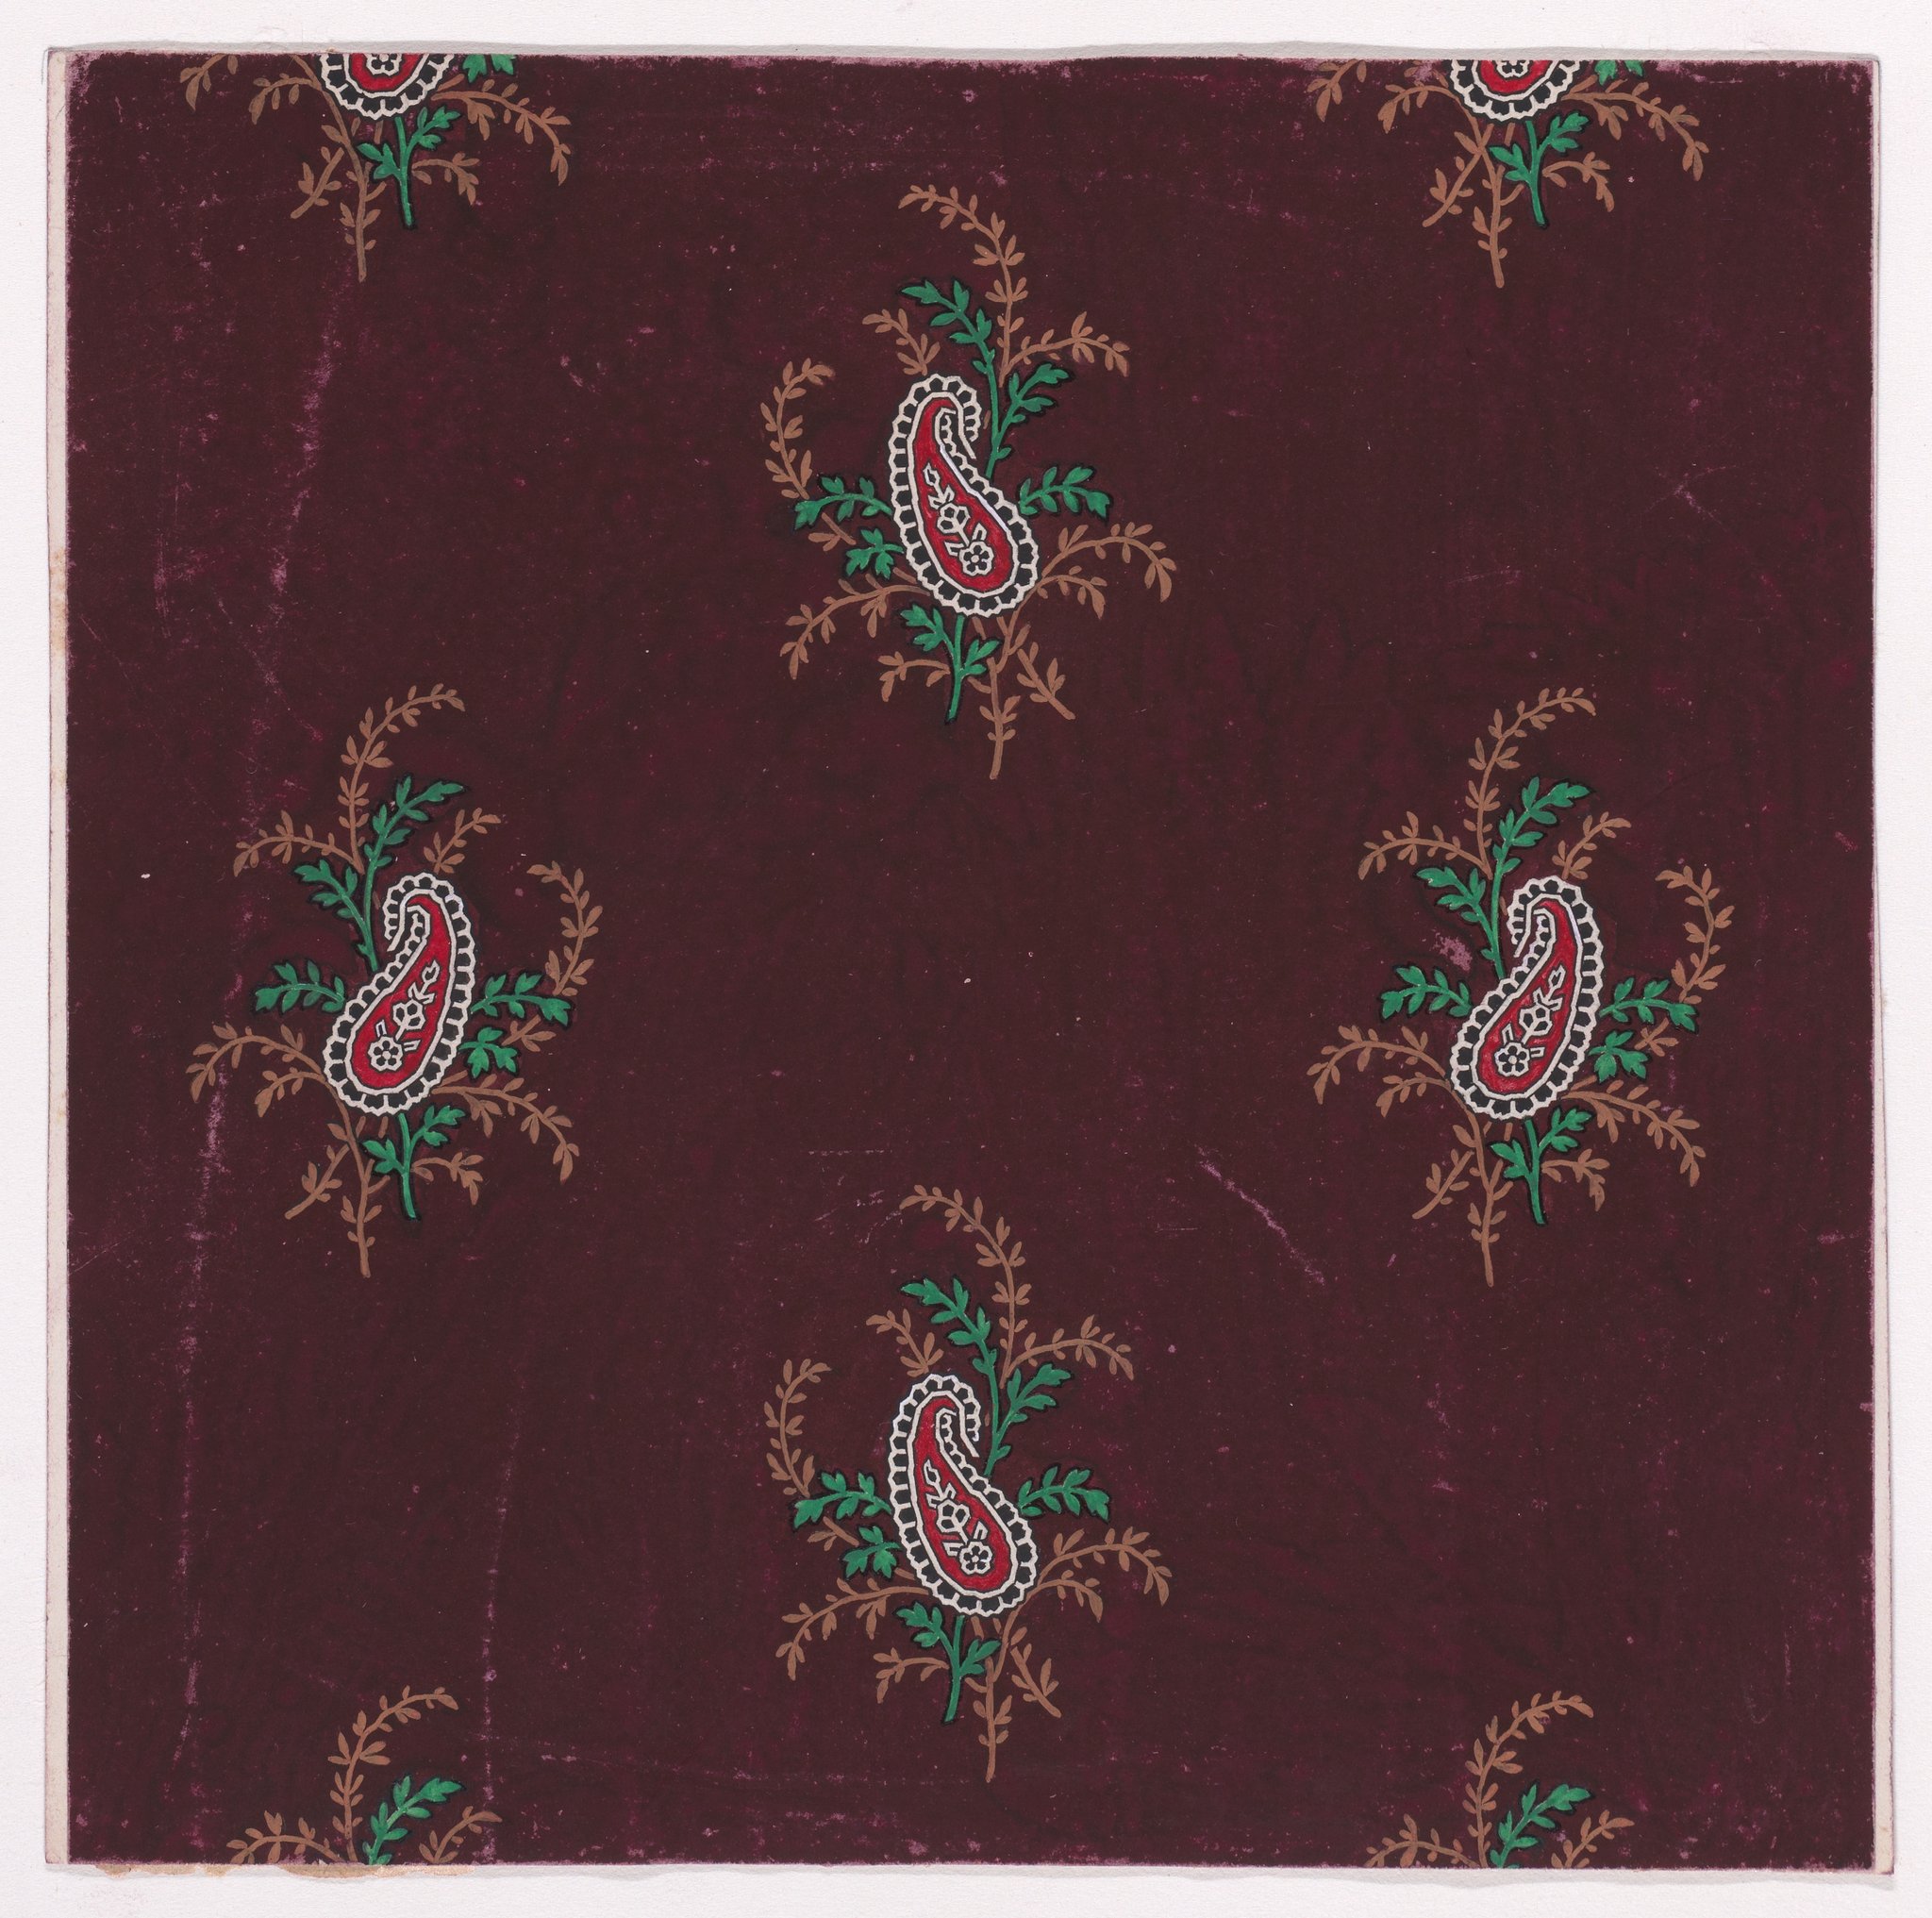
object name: drawing ornament architecture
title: Textile Design with Alternating Rows of Bunches of Scrolling Branches with Stylized Leaves and a Paisley Motif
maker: anonymous, alsatian, 19th century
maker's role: artist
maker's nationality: alsatian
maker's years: 1800-1900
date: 1840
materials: gouache